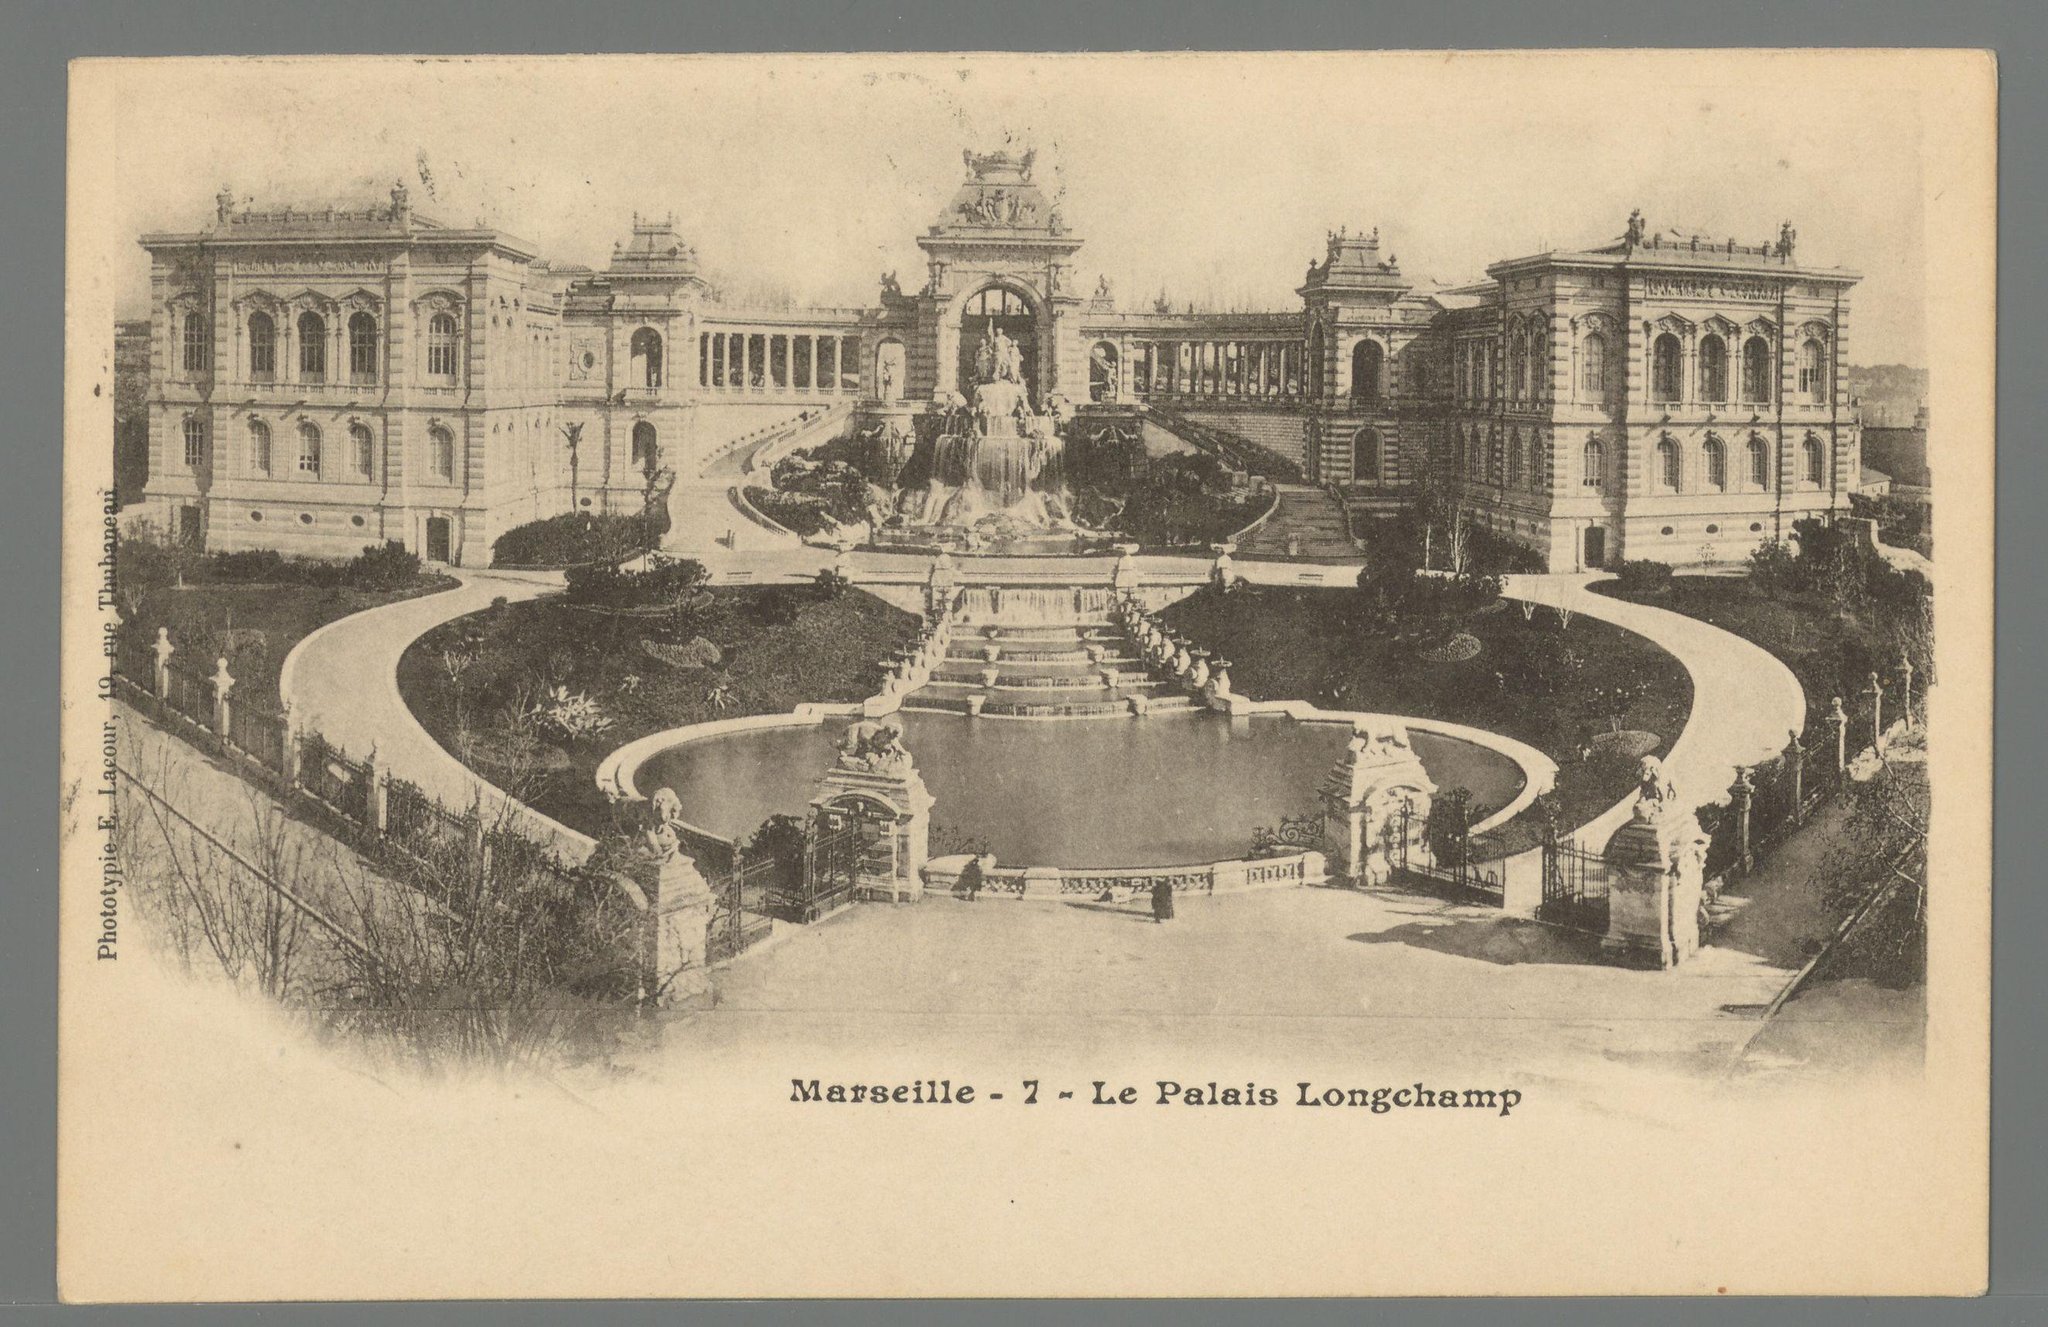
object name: photomechanical print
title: Marseille (...). Le Palais Longchamp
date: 1900-1903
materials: cardboard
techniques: photograph, writing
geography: marseille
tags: park, palace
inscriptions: postage stamp